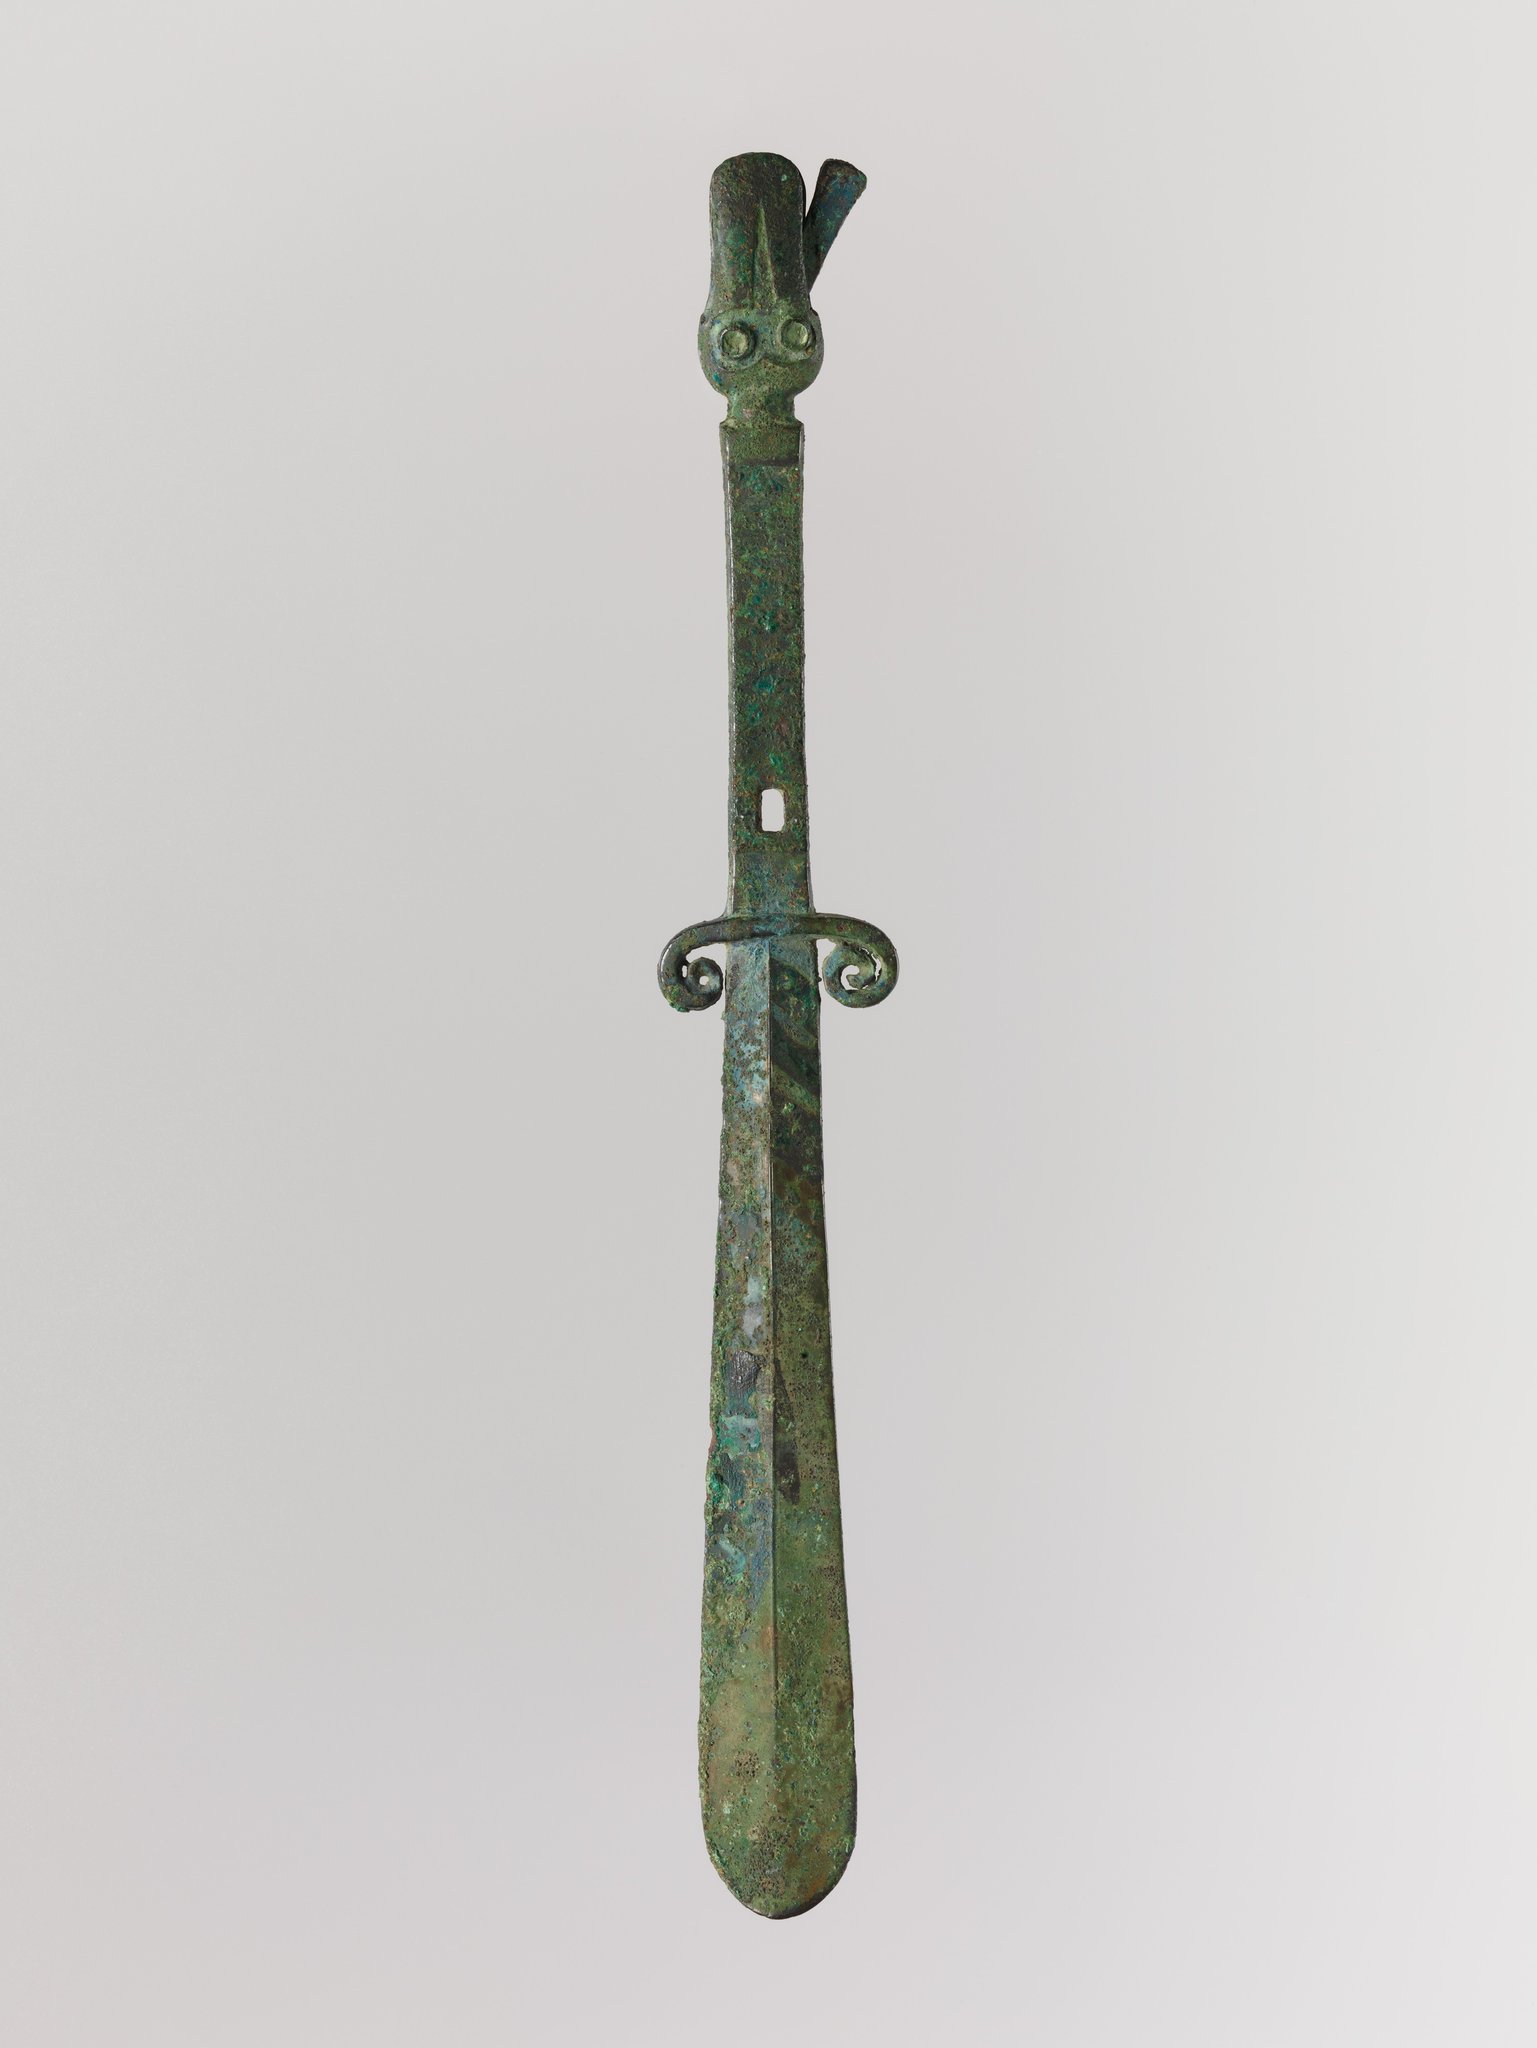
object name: implement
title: Implement with Curved Blade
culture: chinese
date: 1300-1001 BCE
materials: bronze